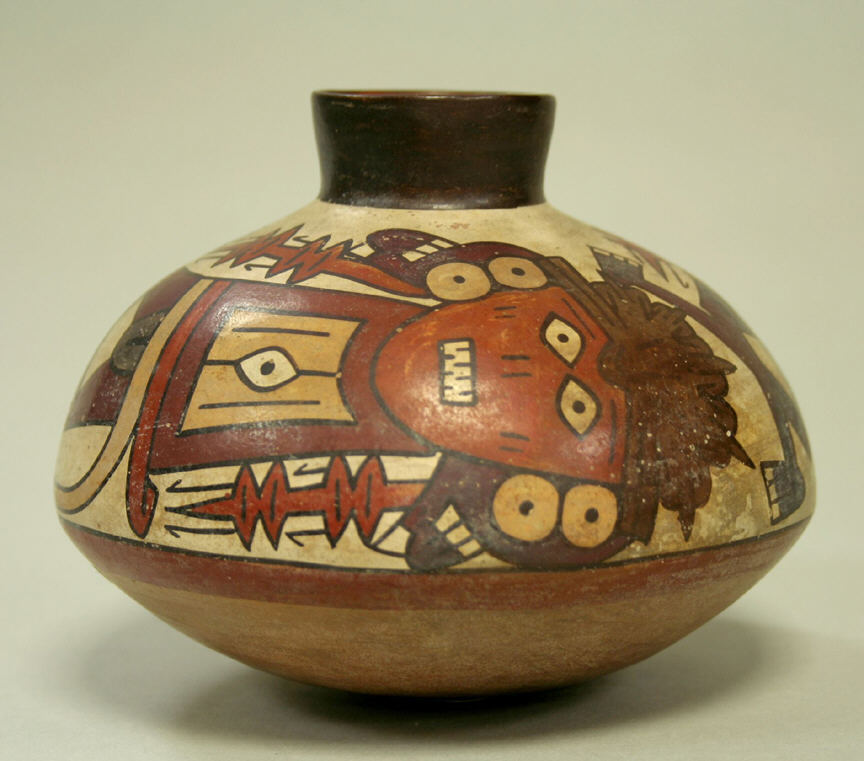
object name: jar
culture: nasca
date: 1-600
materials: ceramic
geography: peru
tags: human figures